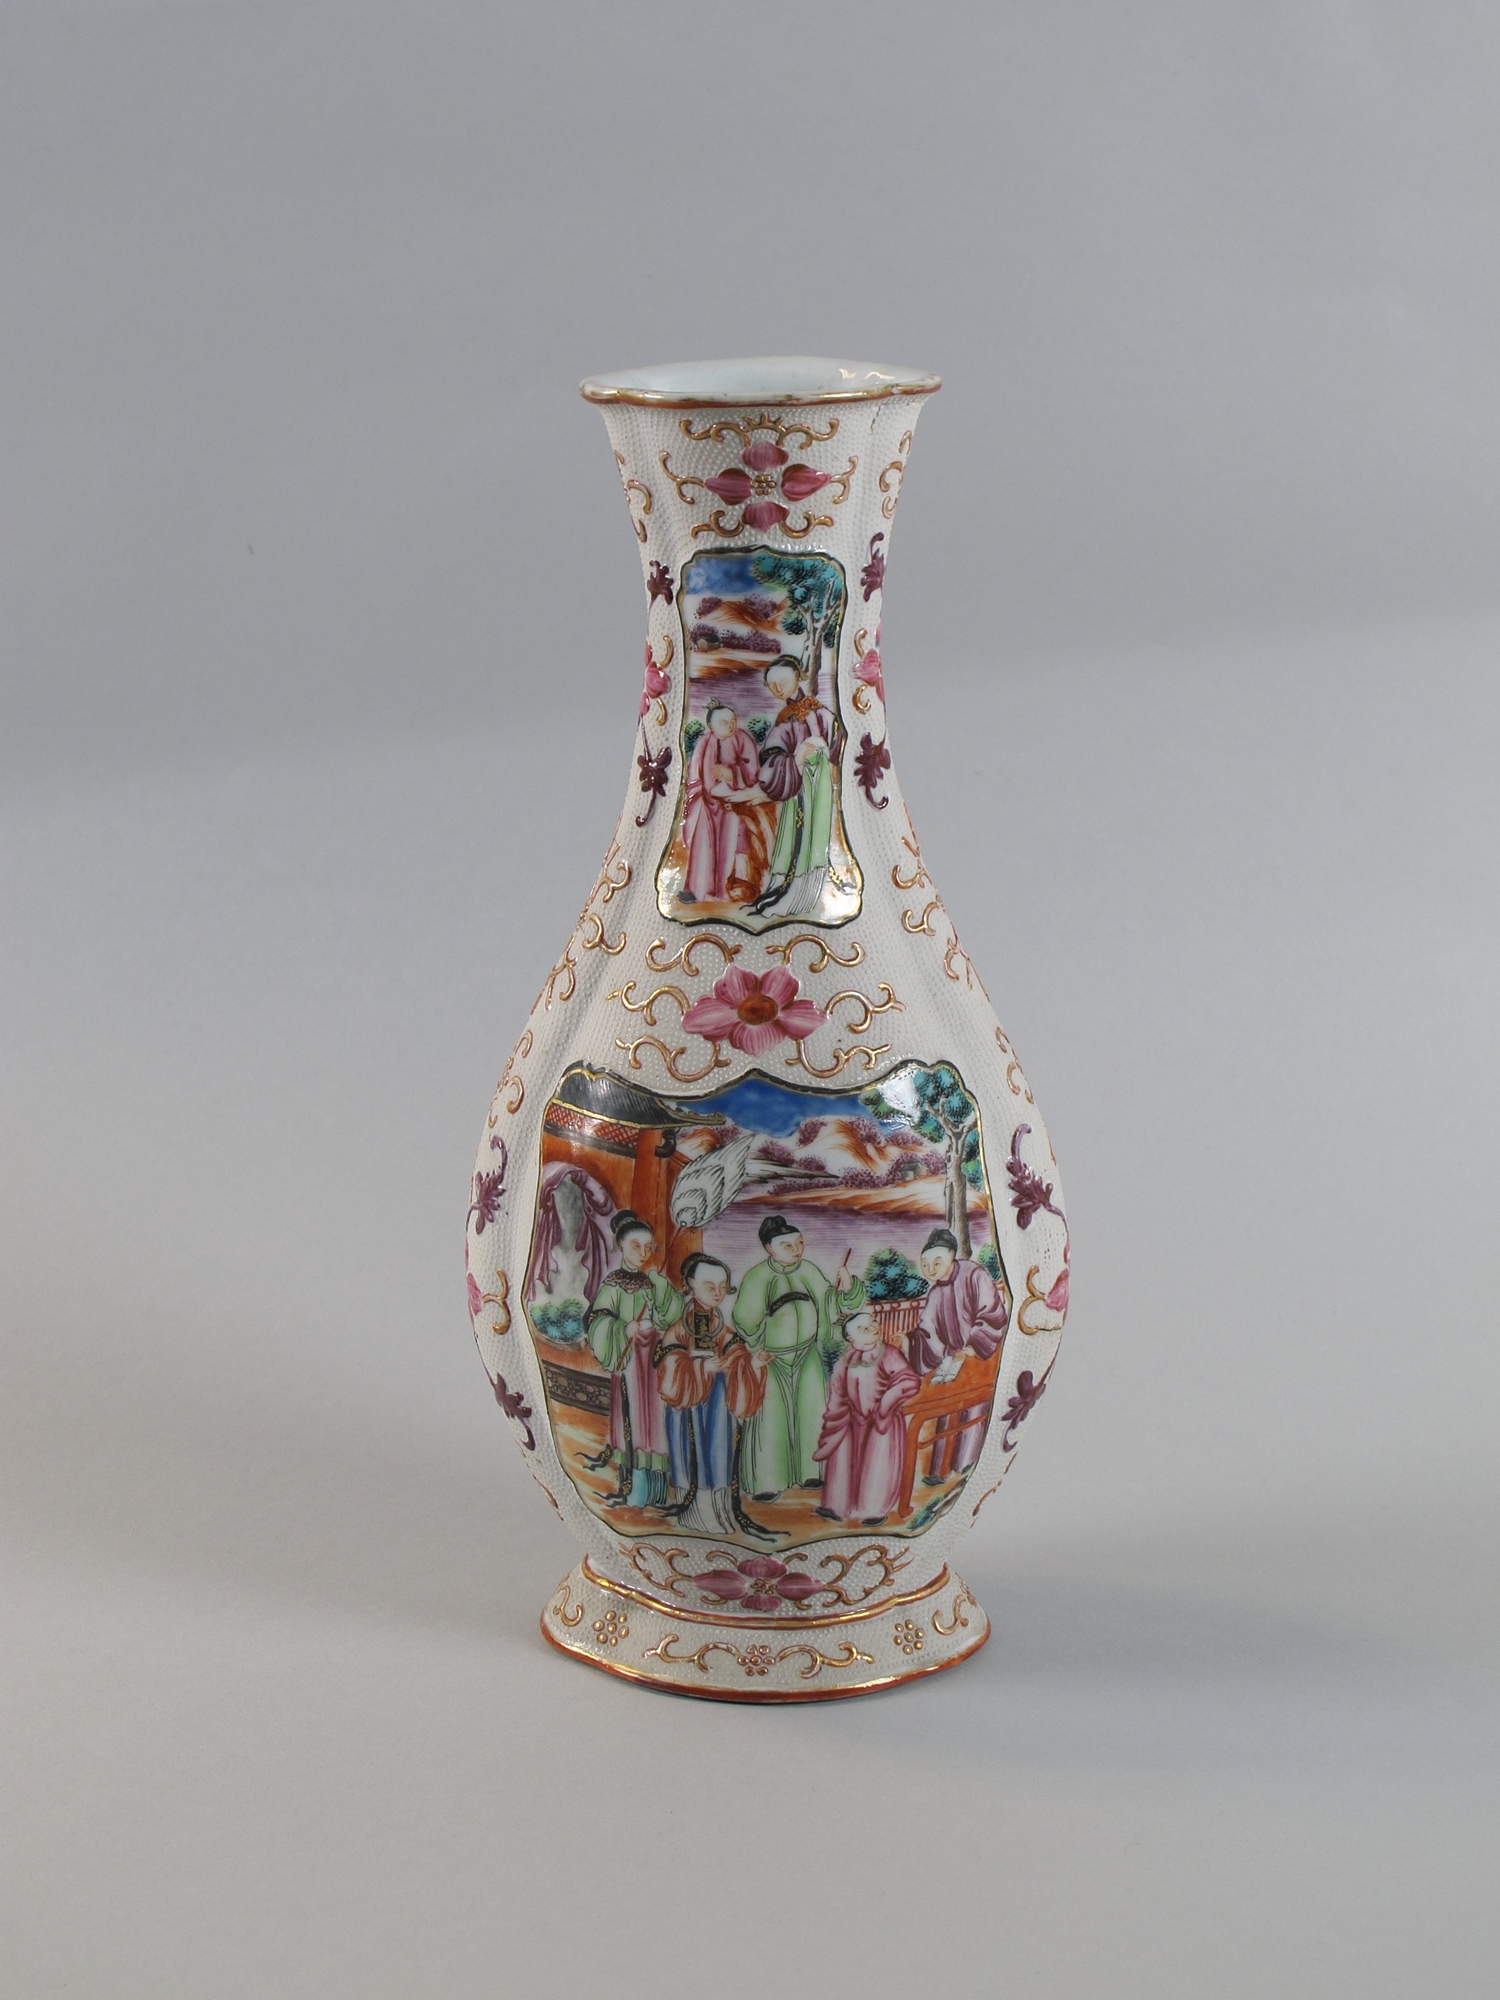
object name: vase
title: Vase with figures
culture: chinese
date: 1801-1900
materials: enamel, porcelain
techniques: overglaze, painting, polychrome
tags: human figures